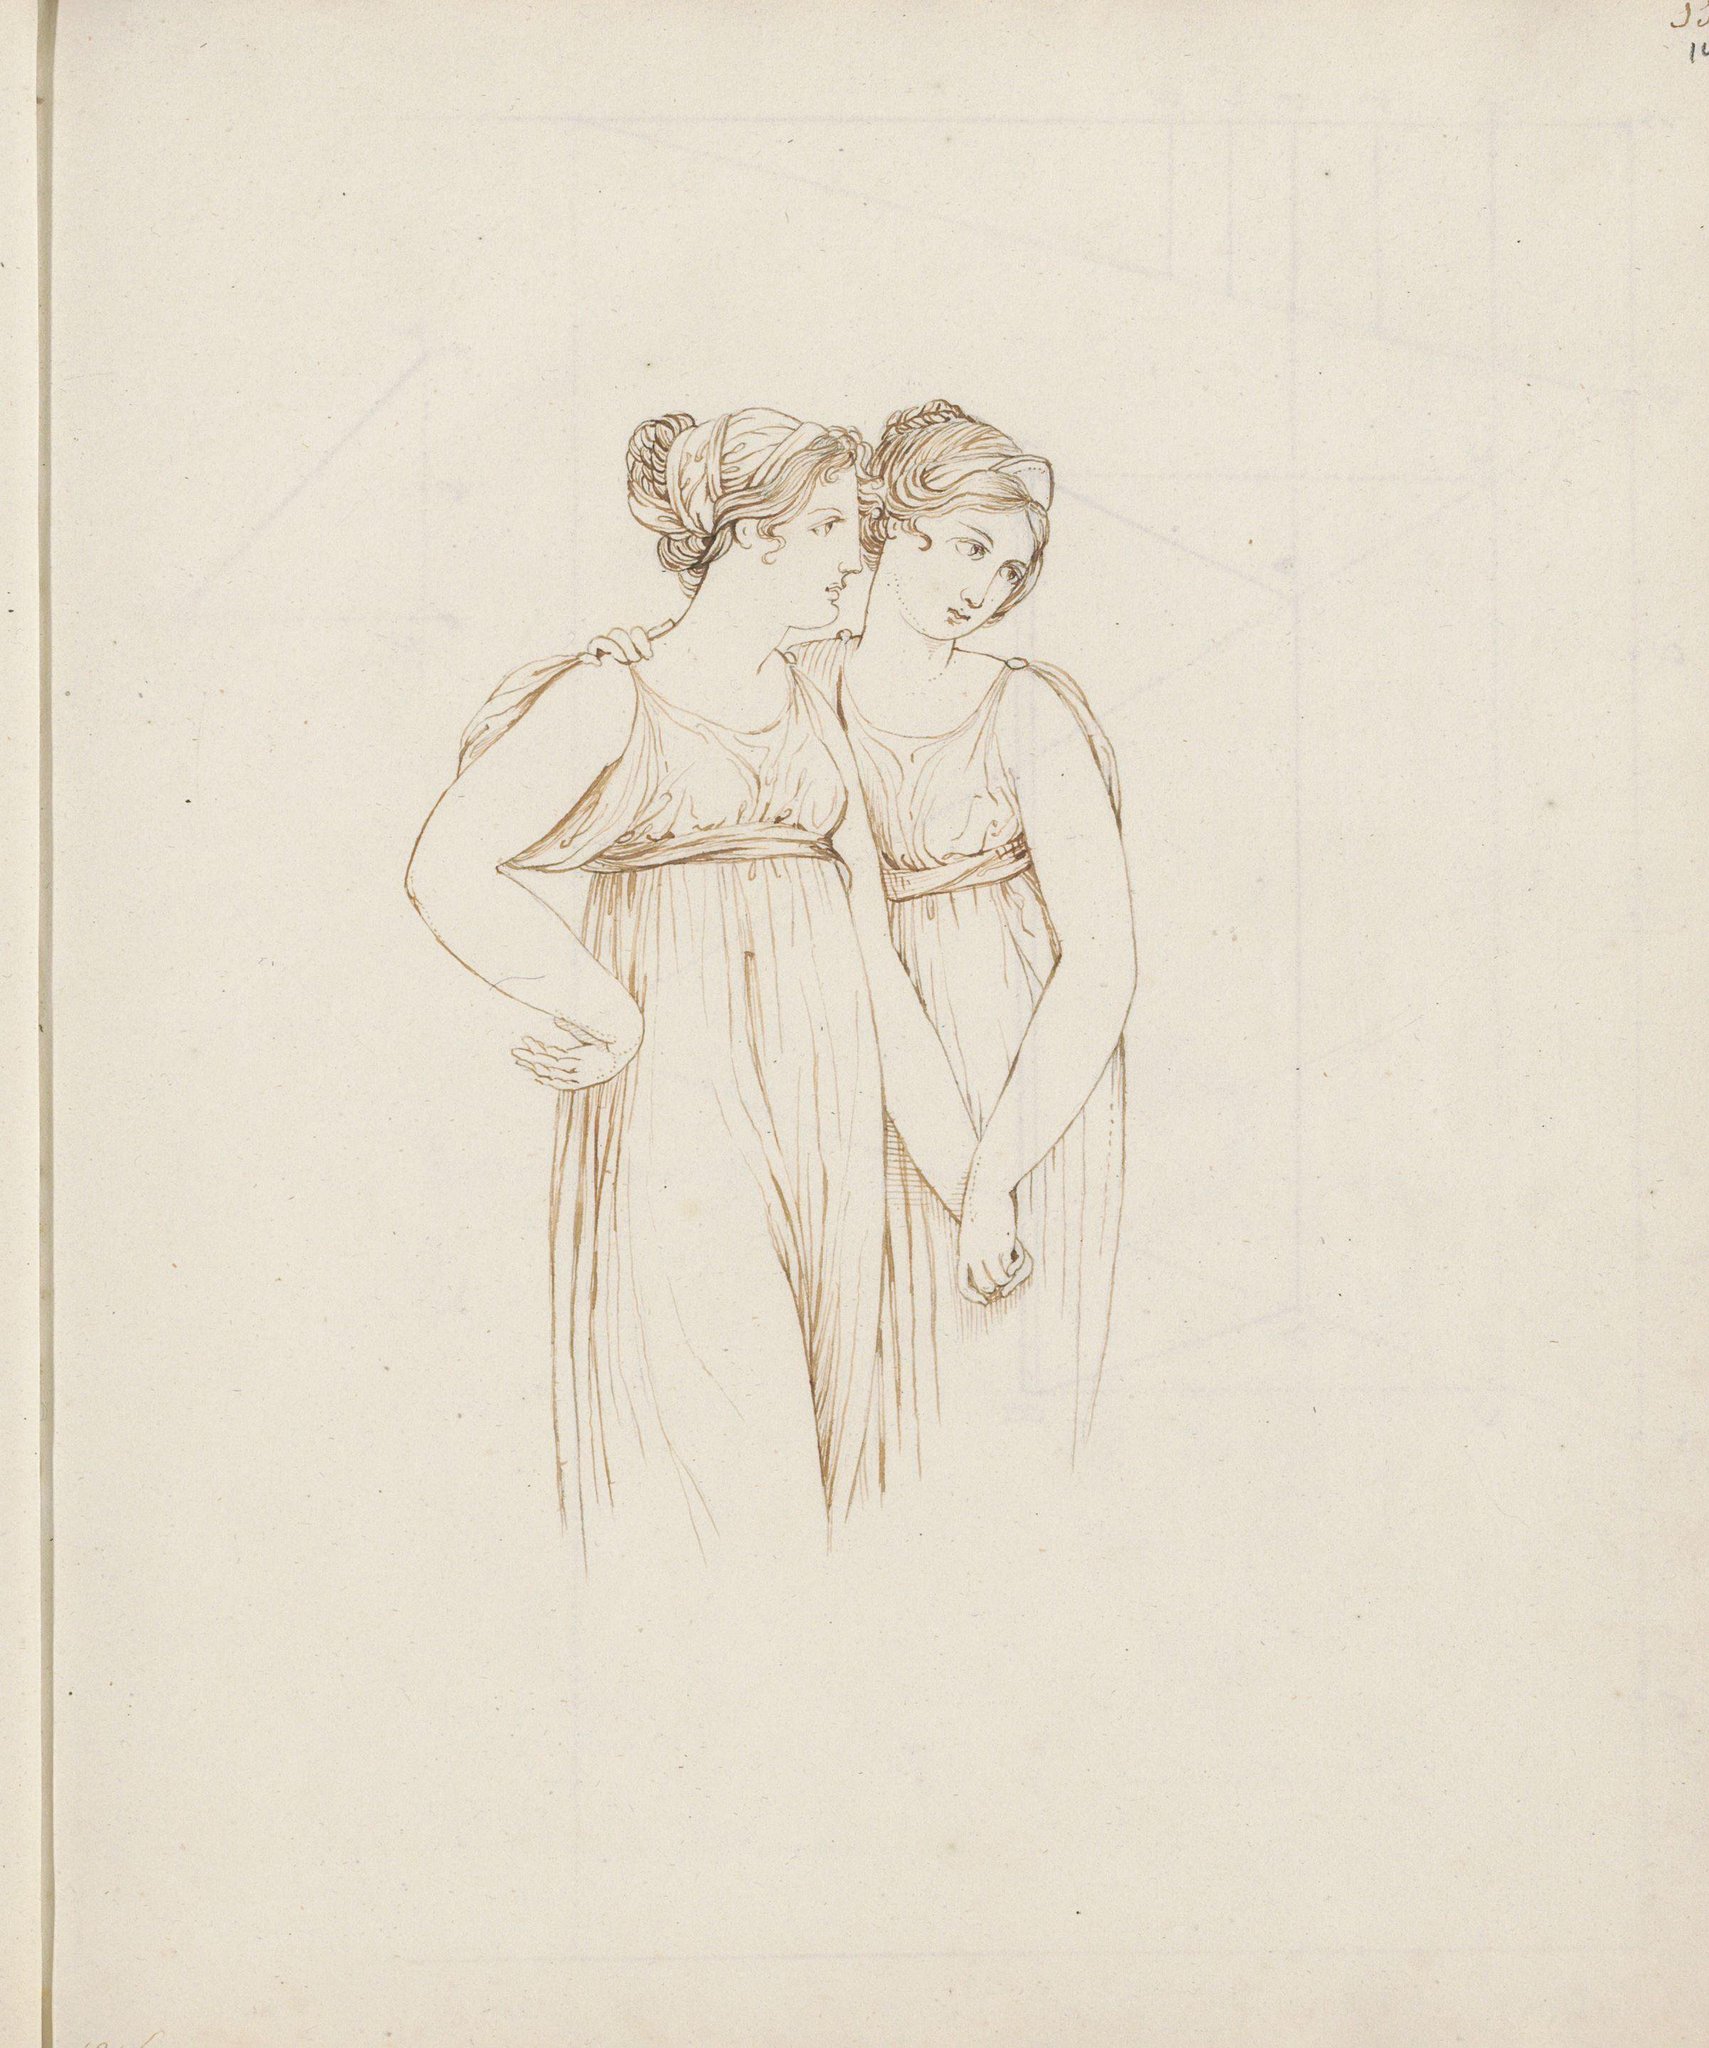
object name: sketchbook leaf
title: Twee vrouwen die elkaars hand vasthouden, naar klassiek voorbeeld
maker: jonkvrouw elisabeth kemper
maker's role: draughtsman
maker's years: 1799-1871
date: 1815-1852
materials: ink, paper, pencil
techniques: pen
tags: postures and gestures of arm(s) and hand(s) in relation to another person, female persons from classical history (+ belonging to greek history)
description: De vrouwen dragen beiden een chiton. Eén vrouw legt haar arm op de schouder van de ander. Verbeelding van de vriendschap. Blad 14 recto uit een schetsboek met 94 bladen.